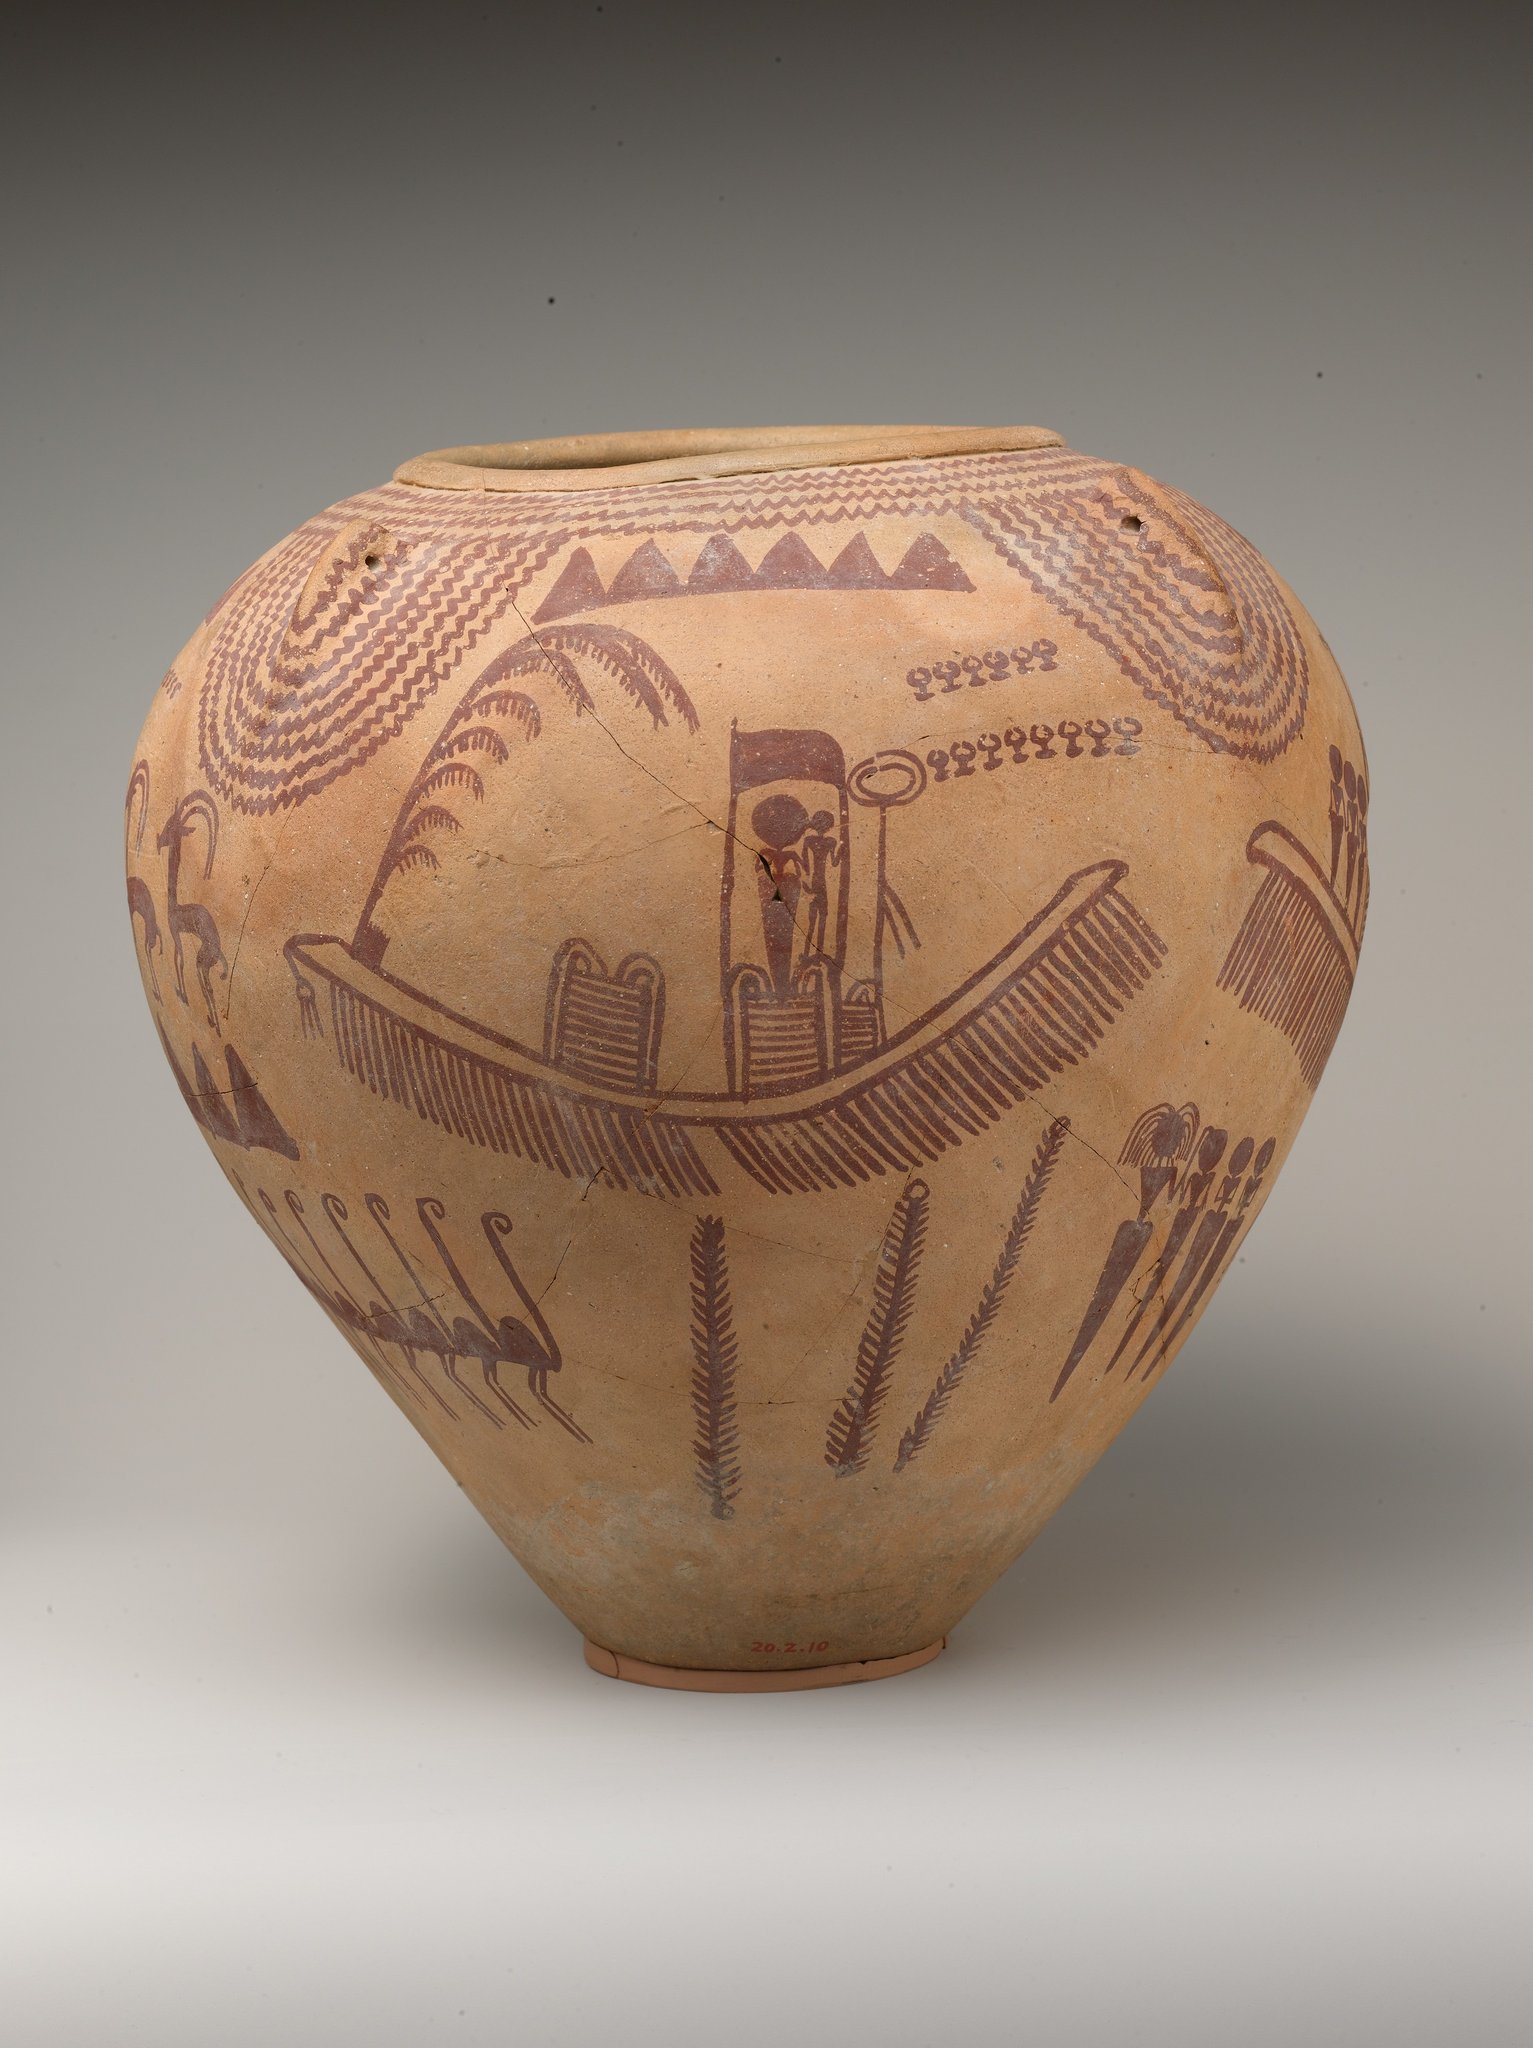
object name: jar, decorated ware, boat, human, ungulate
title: Decorated Ware Jar Depicting Ungulates and Boats with Human Figures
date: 3500-3300 BCE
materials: paint, pottery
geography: egypt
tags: boats